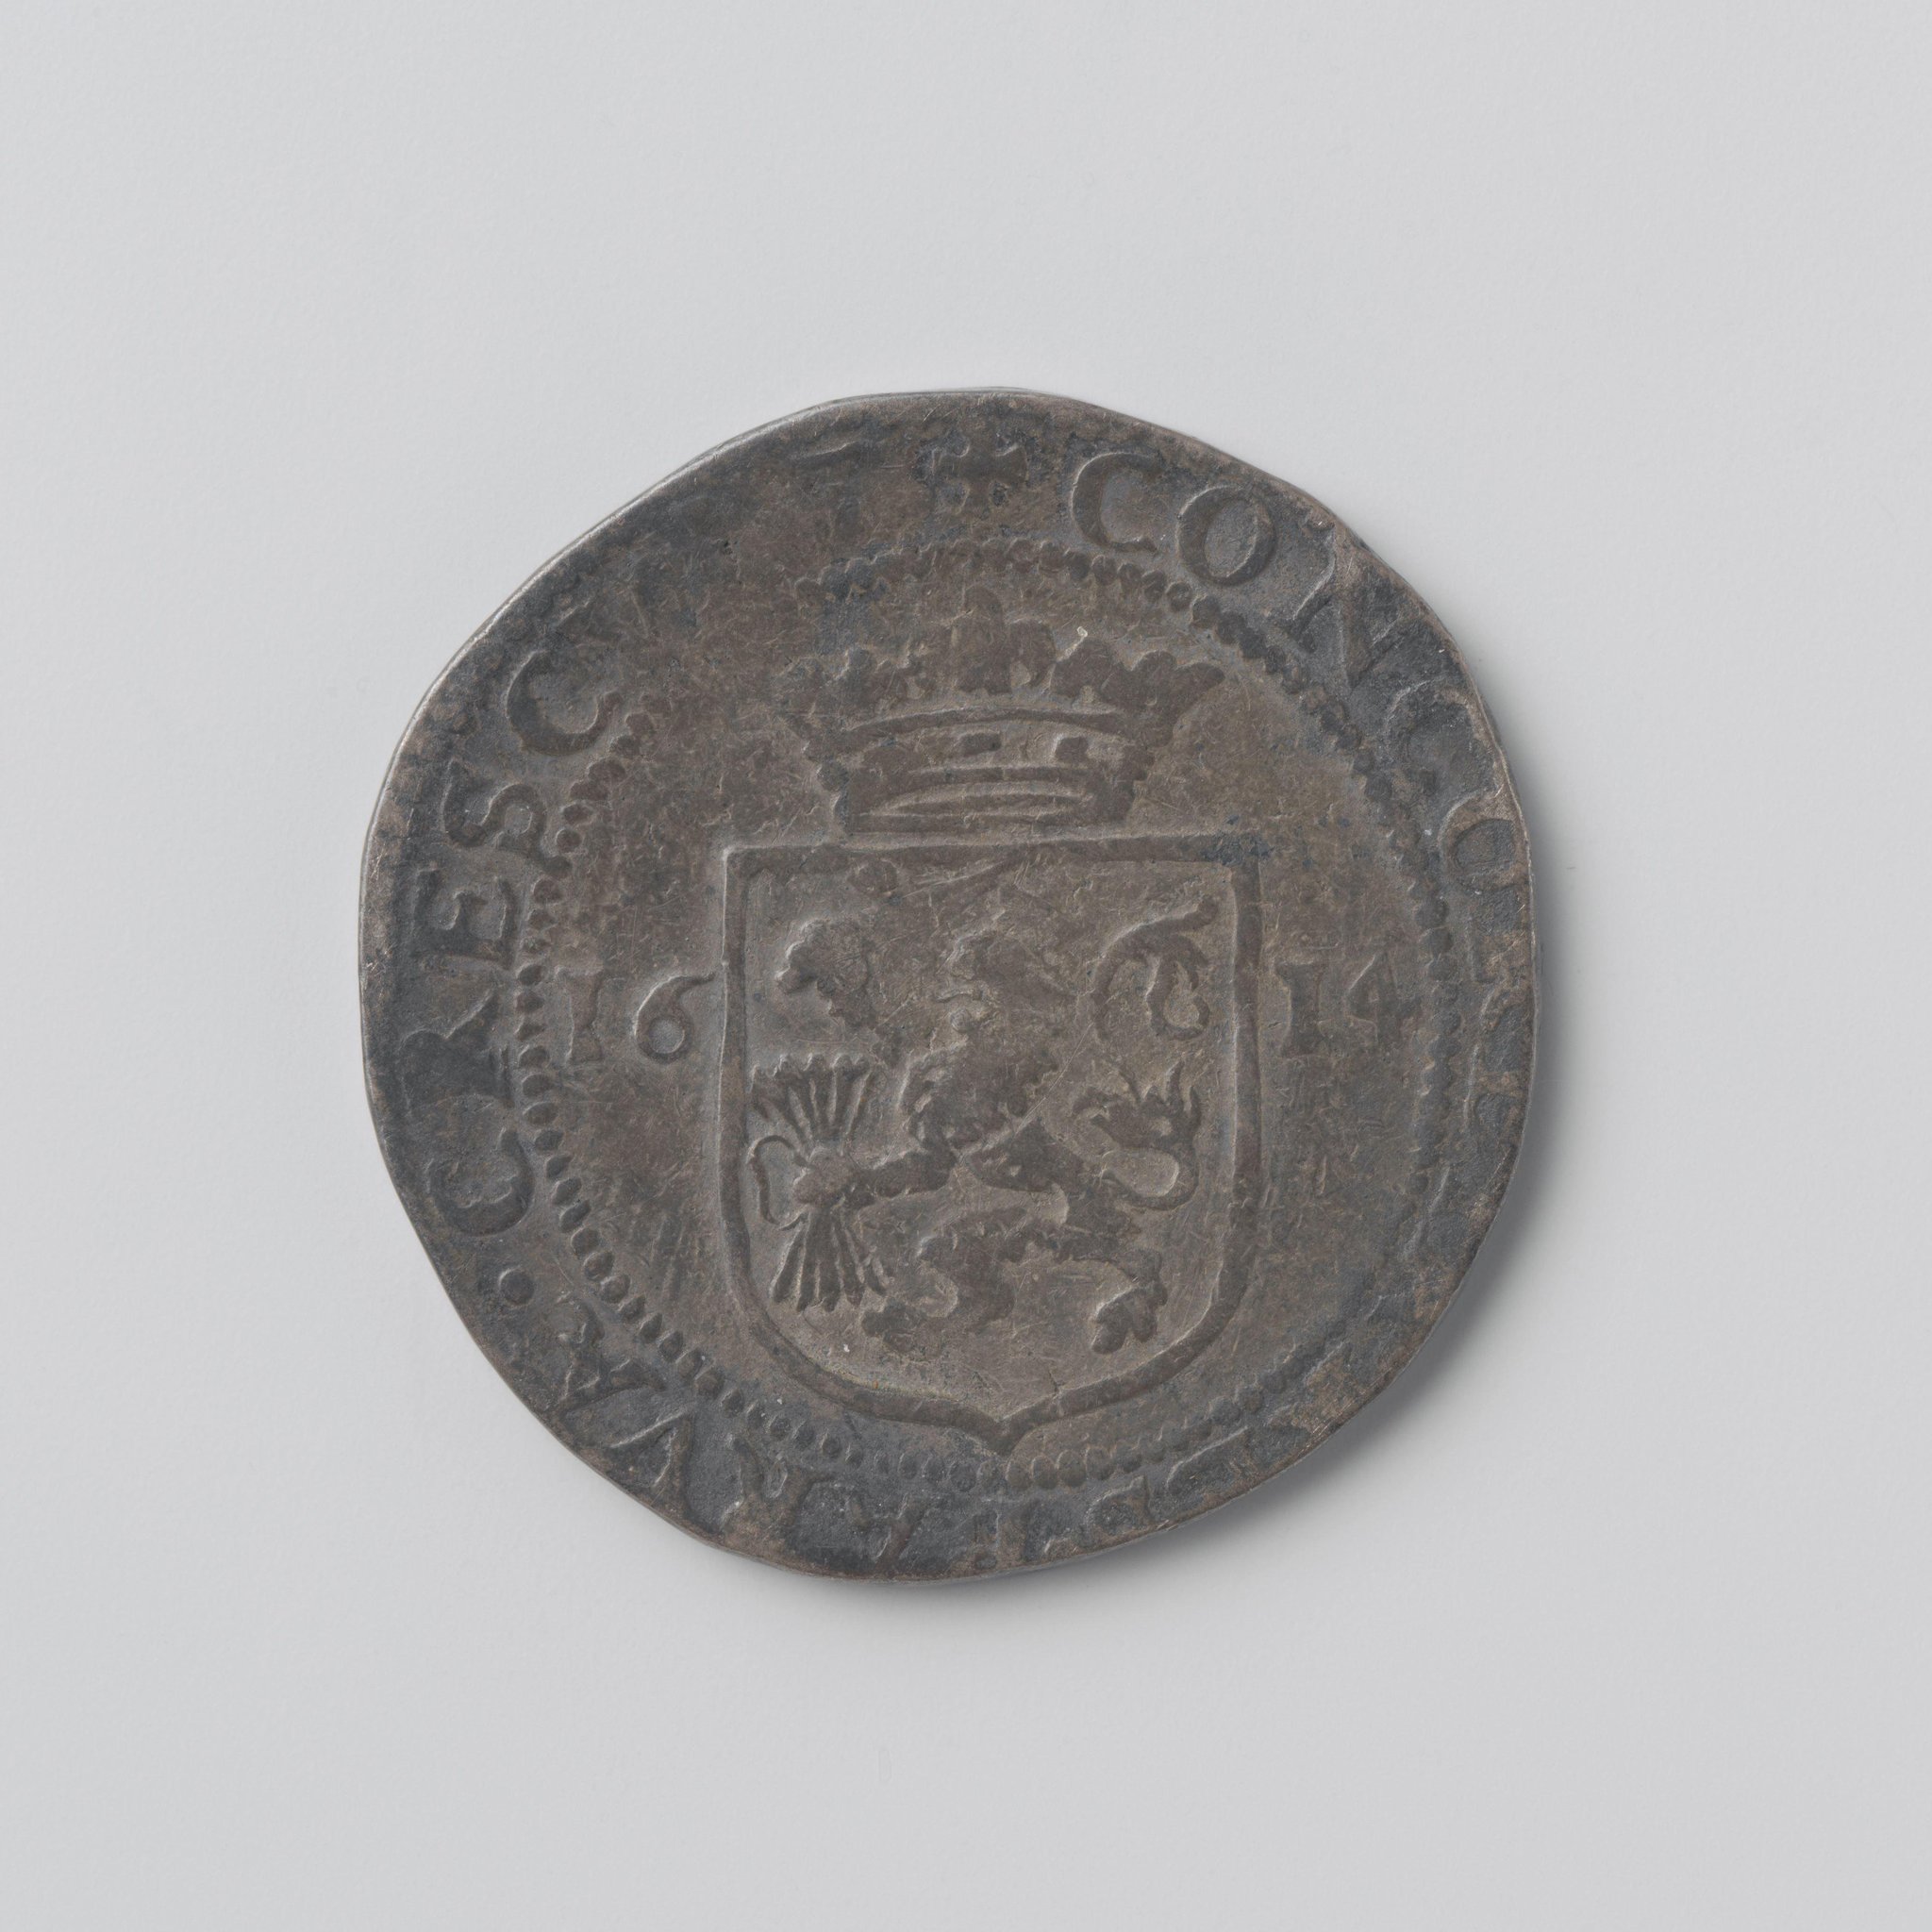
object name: coin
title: Westfriese halve Nederlandse rijksdaalder, 1614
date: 1614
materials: silver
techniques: striking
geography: west frisia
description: Zilveren munt. Voorzijde: gelauwerd en geharnast borstbeeld naar rechts met zwaard in de rechter- en wapenschild van West-Friesland aan lint in linkerhand. Keerzijde: tussen jaartal gekroond generaliteitswapenschild.